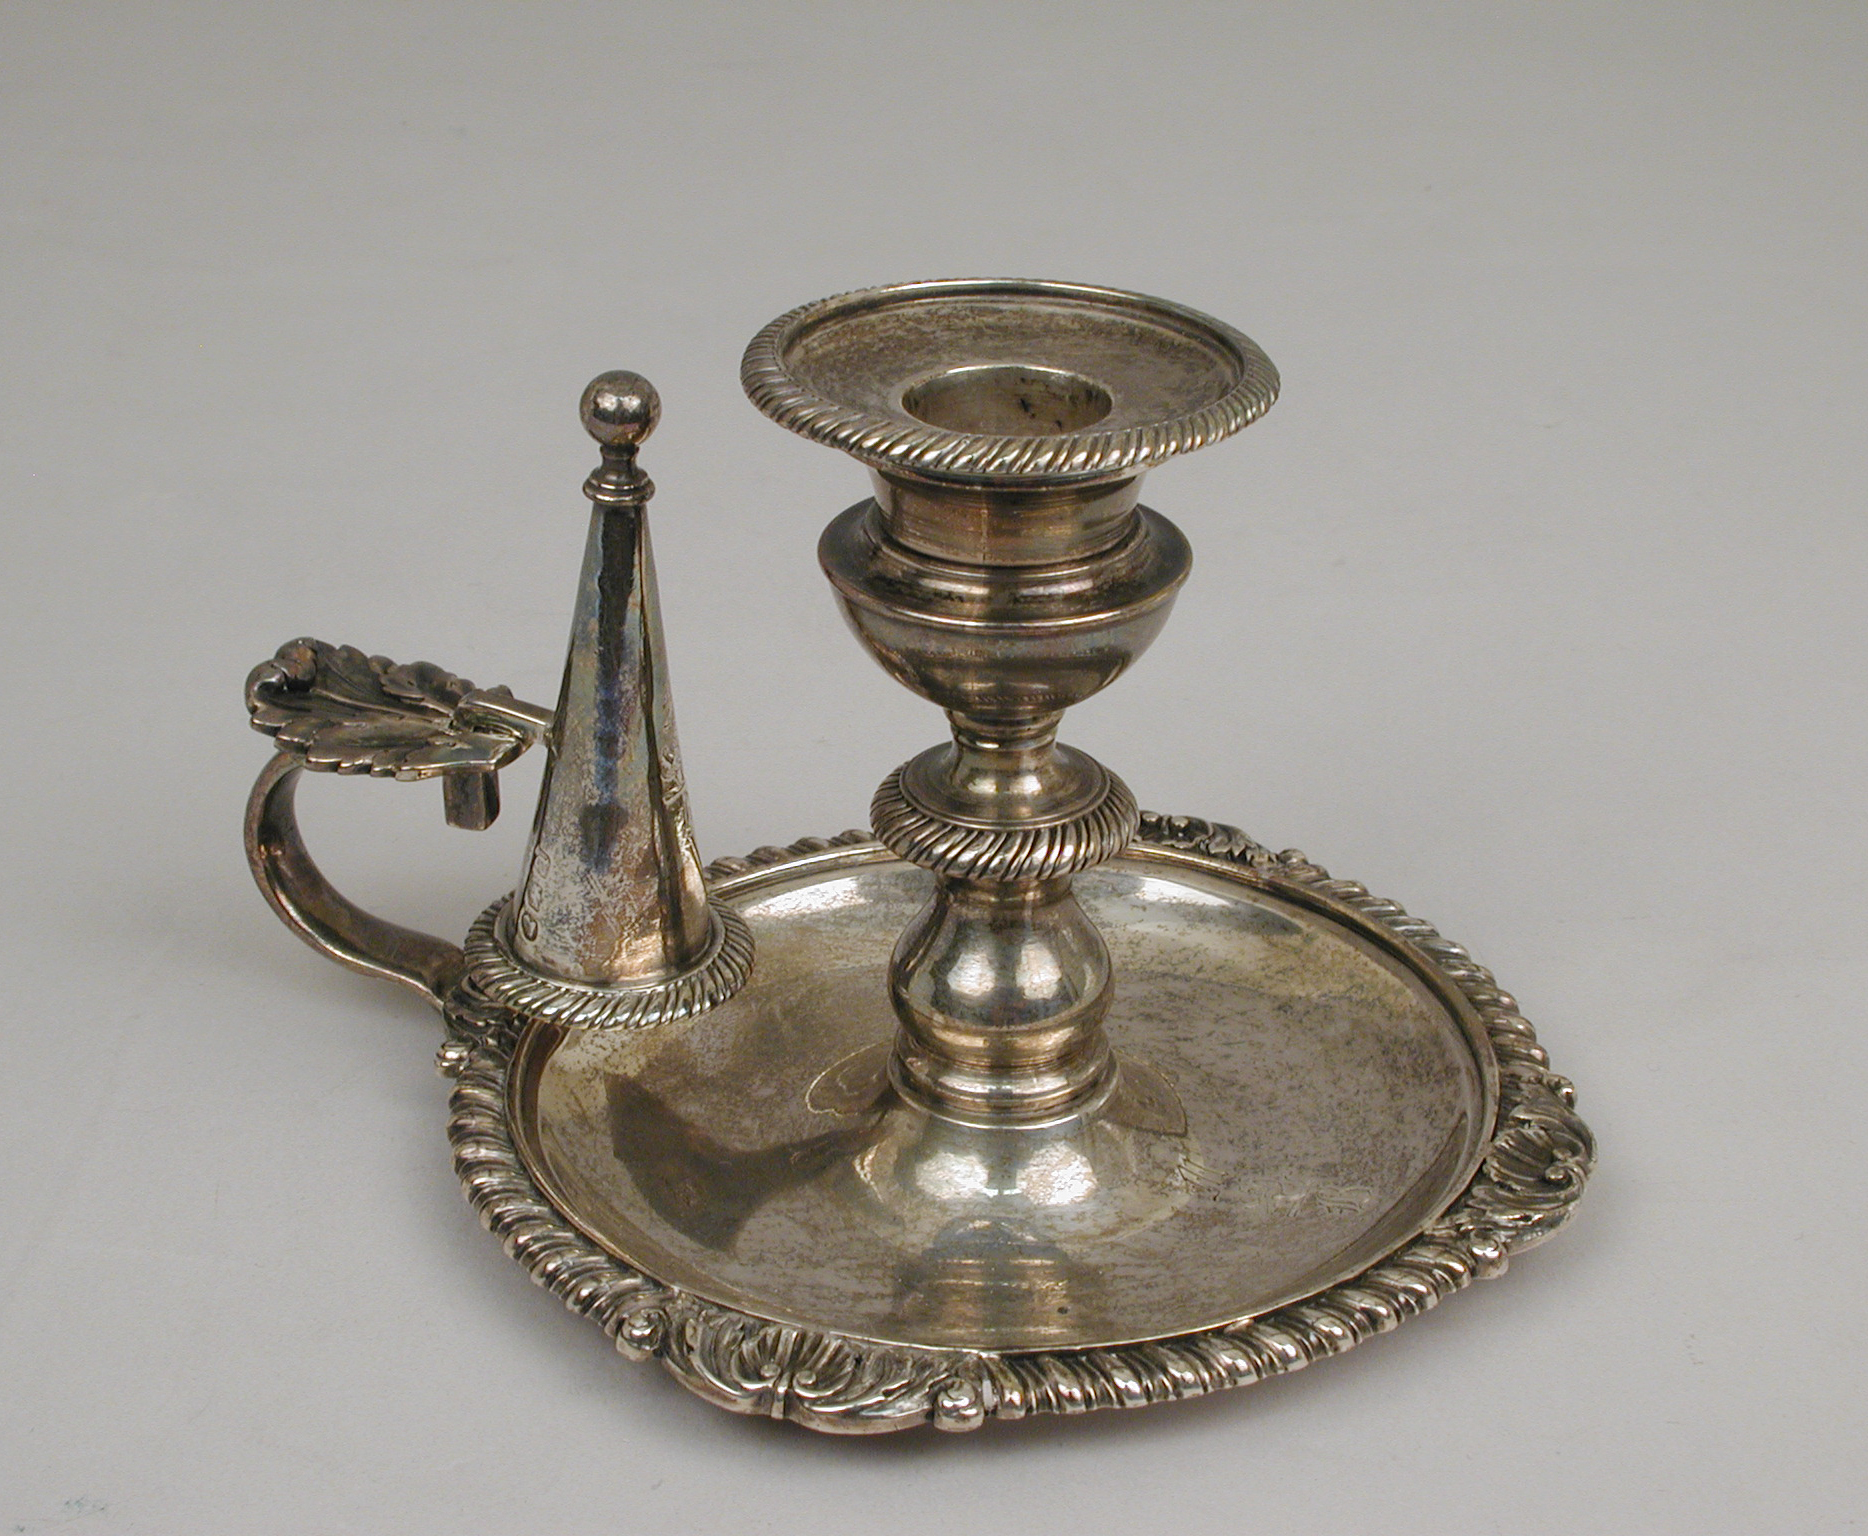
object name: chamberstick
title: Chamberstick (one of a pair)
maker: william elliott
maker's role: maker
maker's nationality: british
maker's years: 1754-1854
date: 1816-1817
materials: silver